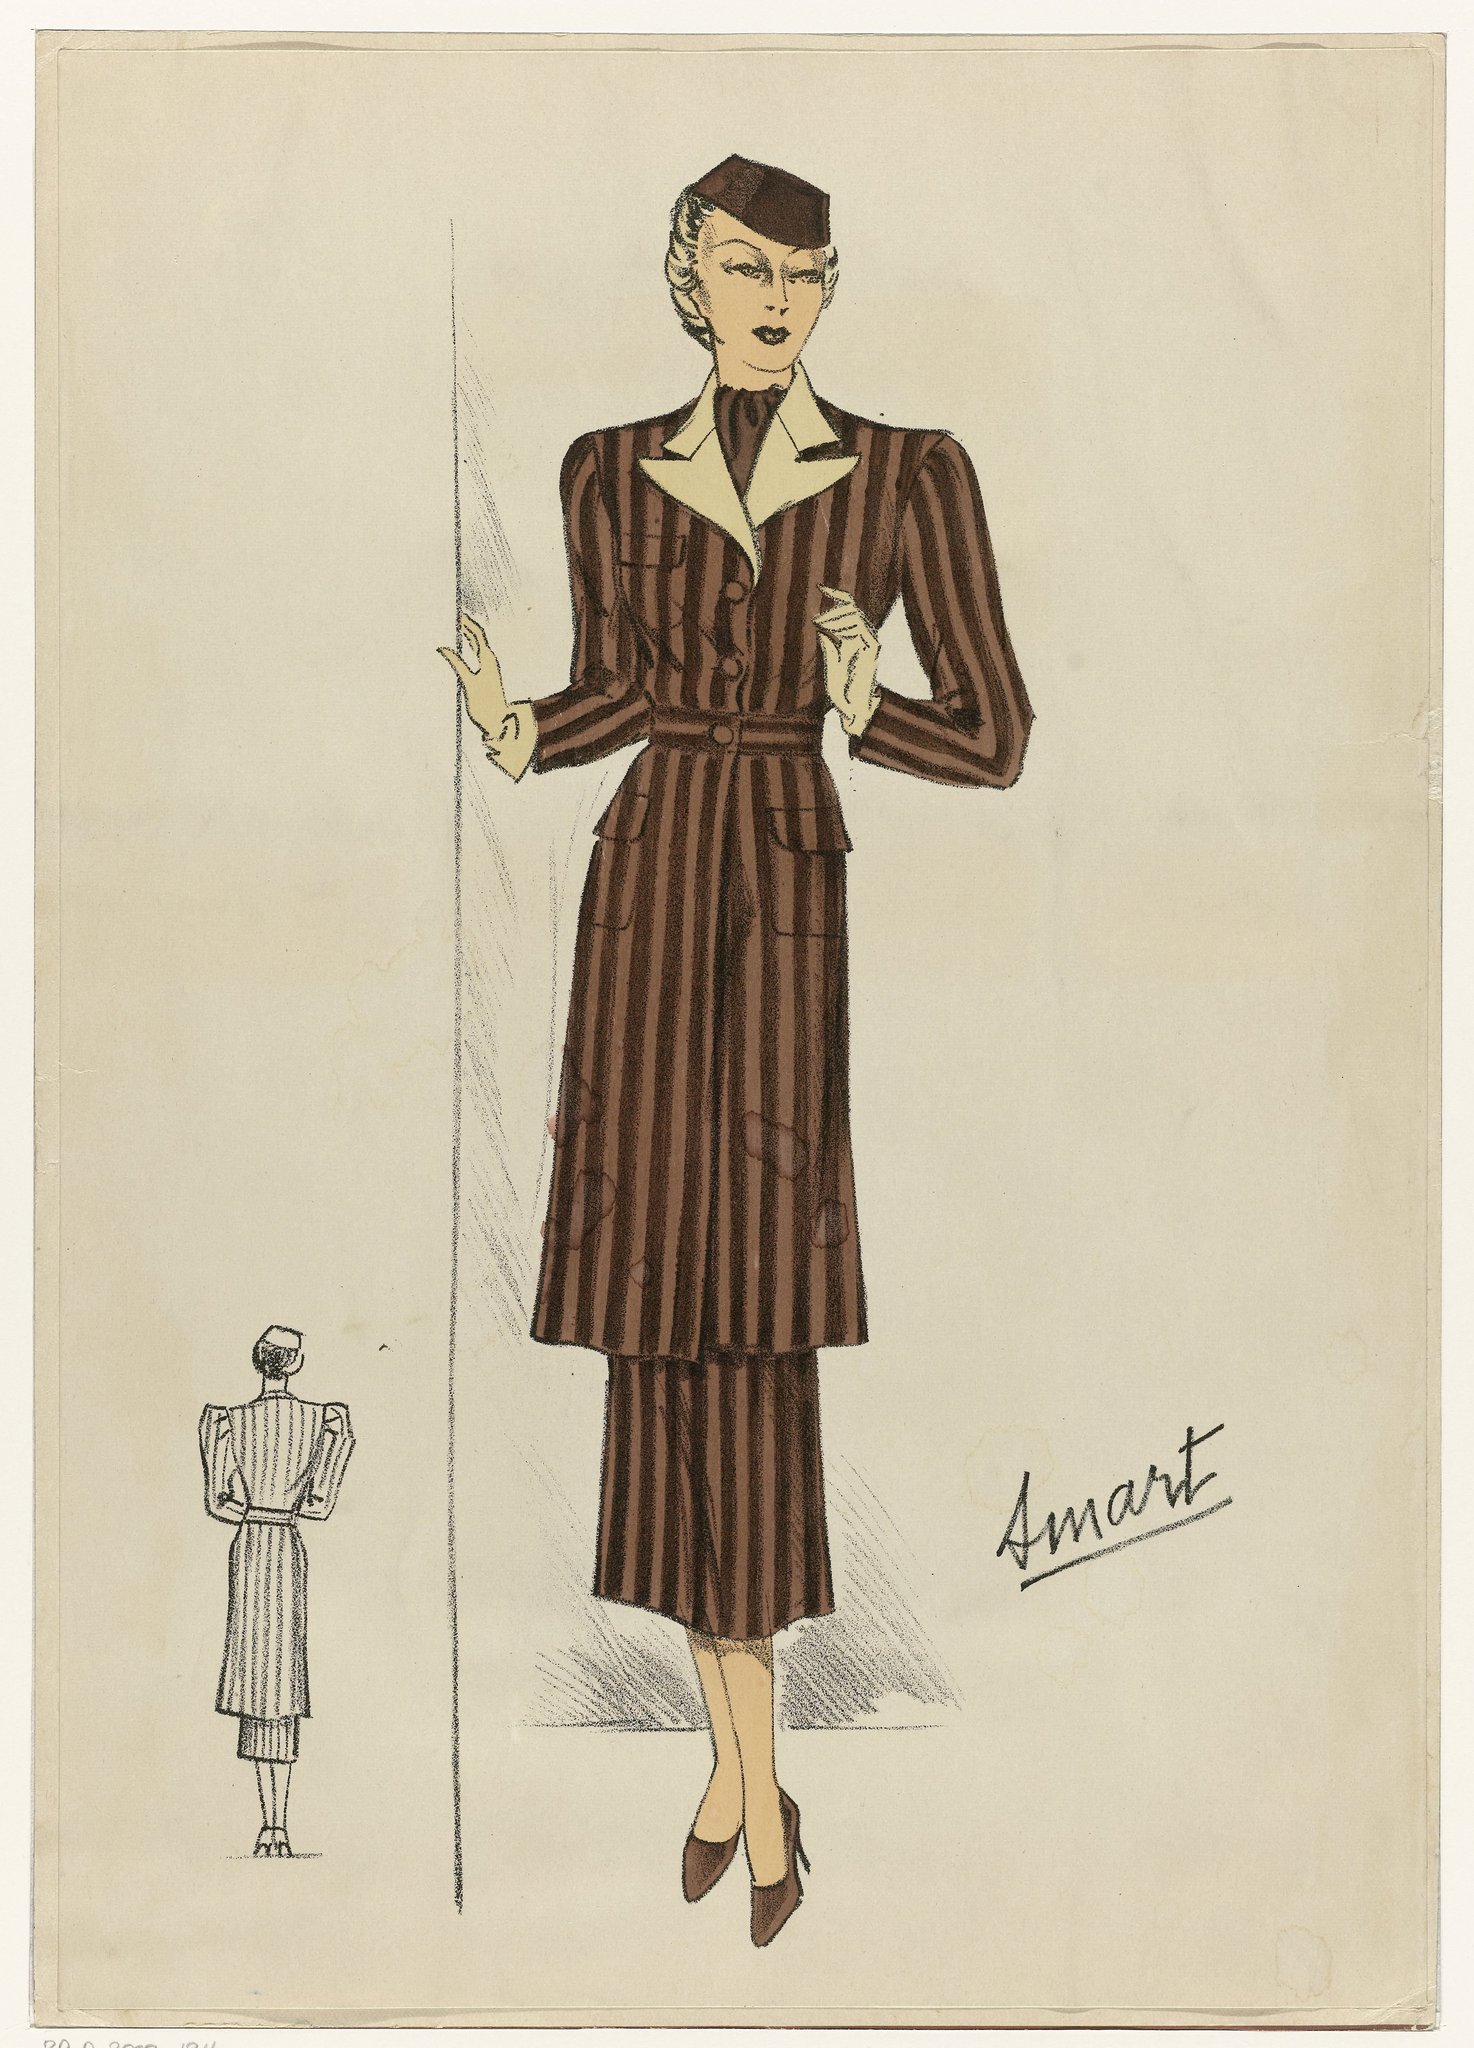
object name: fashion print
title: Vrouw in gestreepte lange jas en rok, ca. 1930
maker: Anonymous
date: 1930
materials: paper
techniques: hand coloring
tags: head-gear: toque (+ women's clothes), ensembles of pieces of clothing (two piece suit) (+ women's clothes), coat (+ women's clothes), fashion plates, skirt (+ women's clothes)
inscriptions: inscription: ‘Smart’, inscription: ‘Largeur 140 cm / Fantaisie laine et angora, pour robe et ensemble / Pon 15967 / Largeur 140 cm / Nouveauté veloutée pour robe et ensemble’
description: Staande vrouw, van voren gezien, in een ensemble van een gestreepte lange jas en rok. Accessoires: randloos hoedje, handschoenen en schoenen met hakken. Linksonder is het ensemble op de rug te zien. Verso: Tien stofstalen.